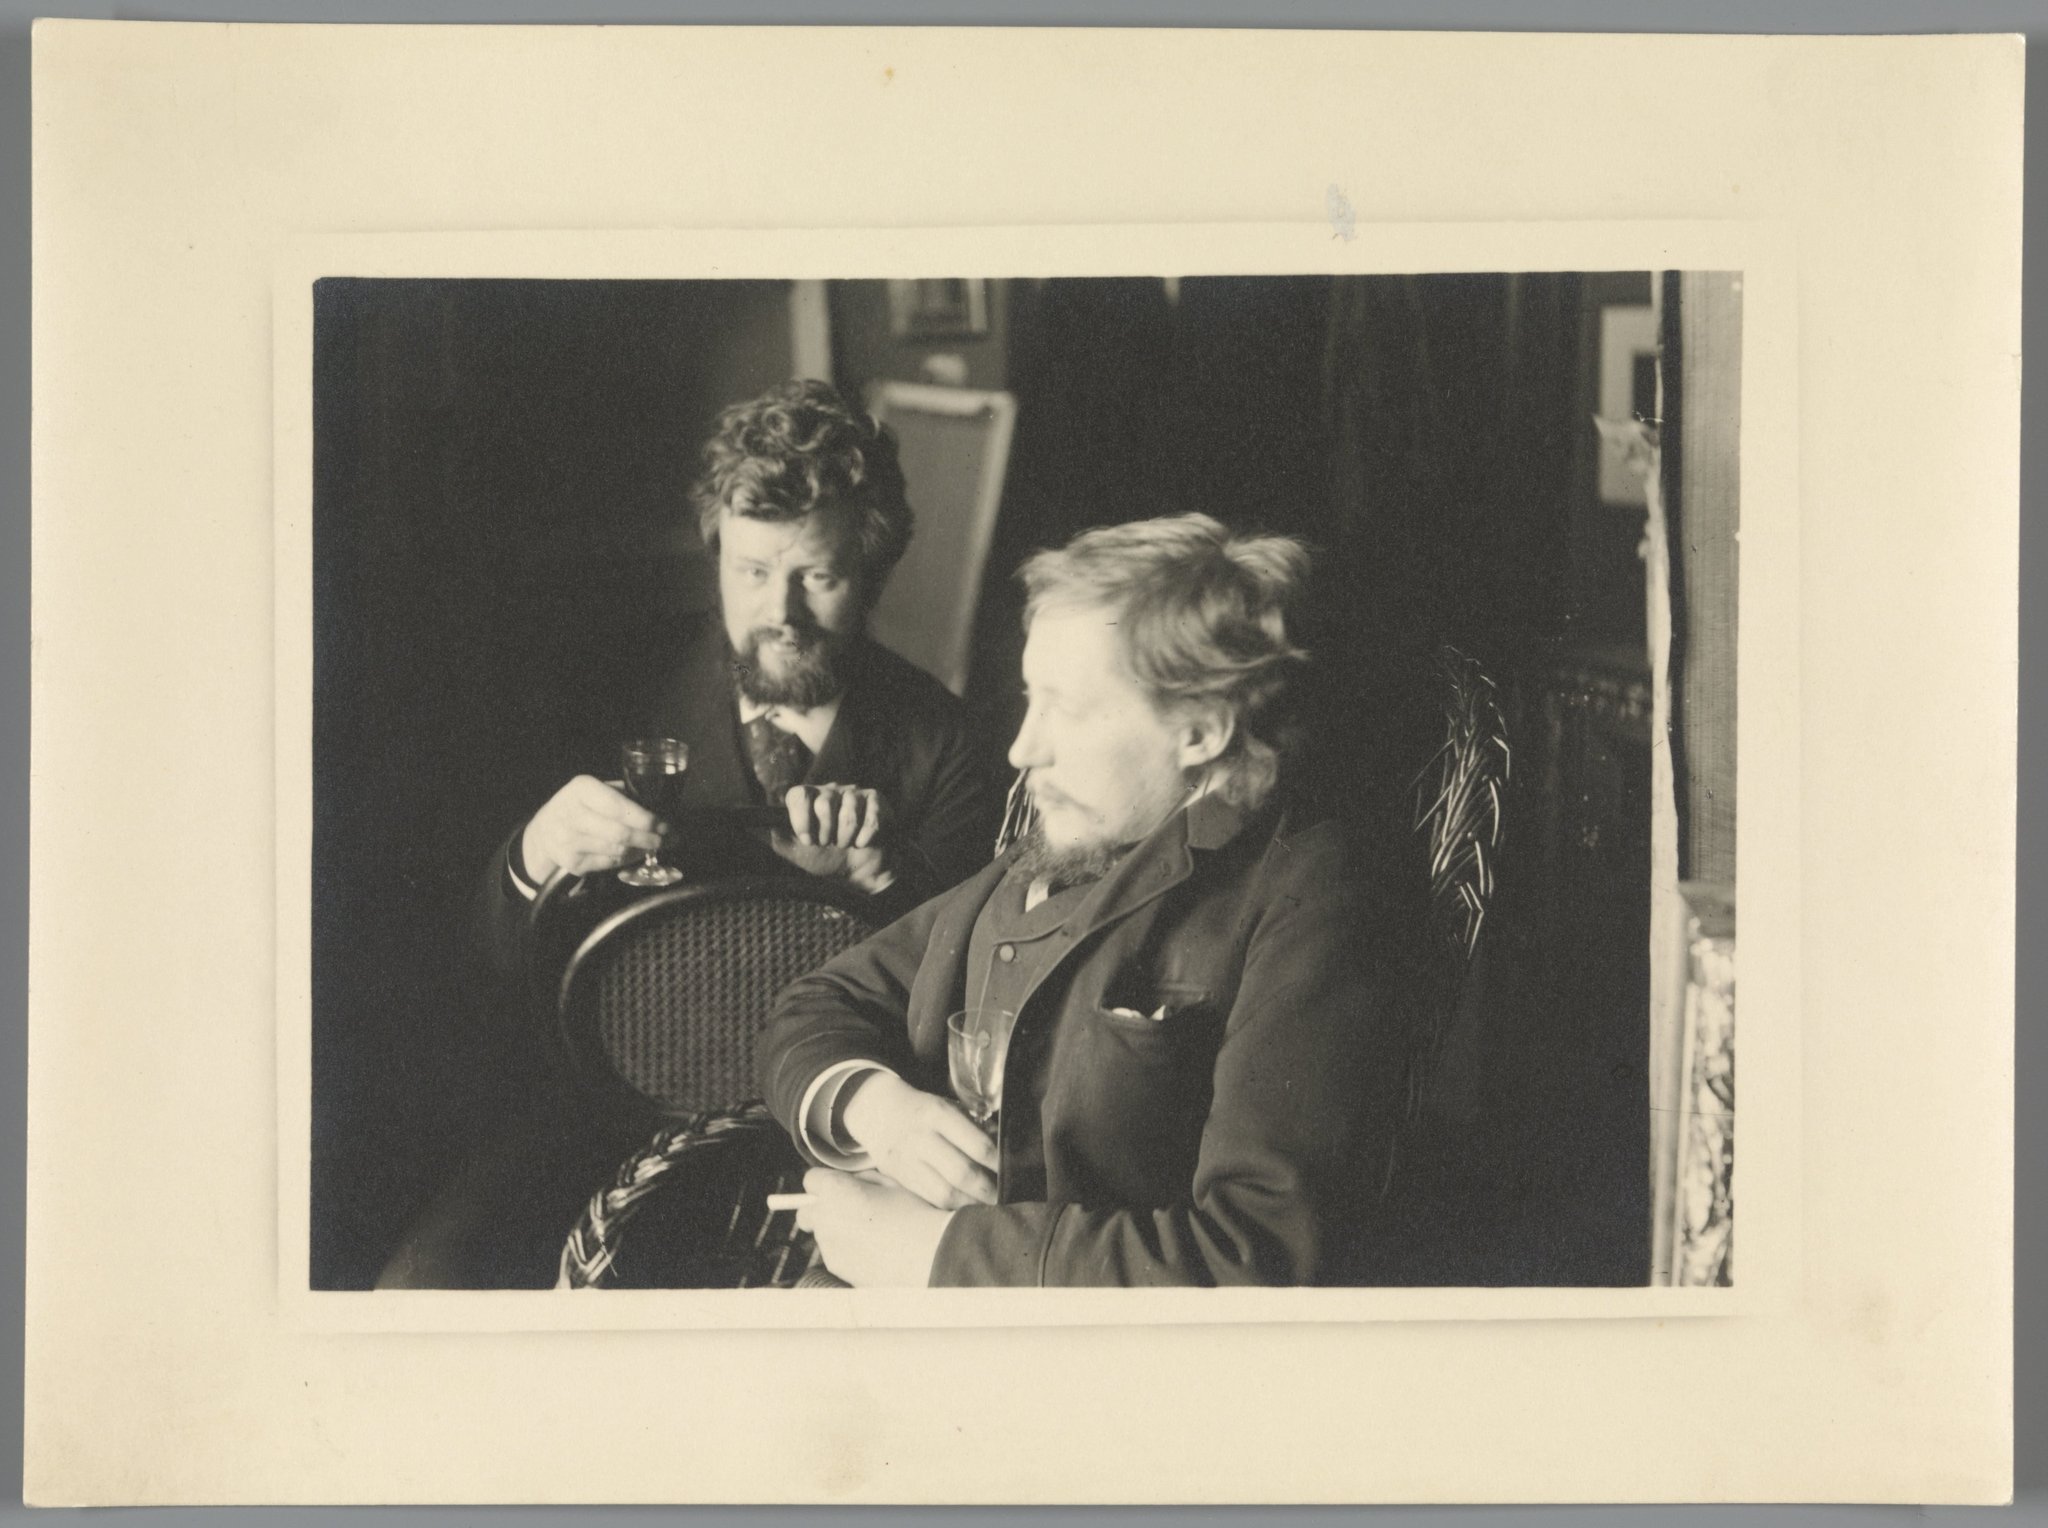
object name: photograph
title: Reproductie naar een foto van Willem Witsen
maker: Anonymous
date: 1860-1915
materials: paper, photographic support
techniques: gelatin silver print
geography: netherlands